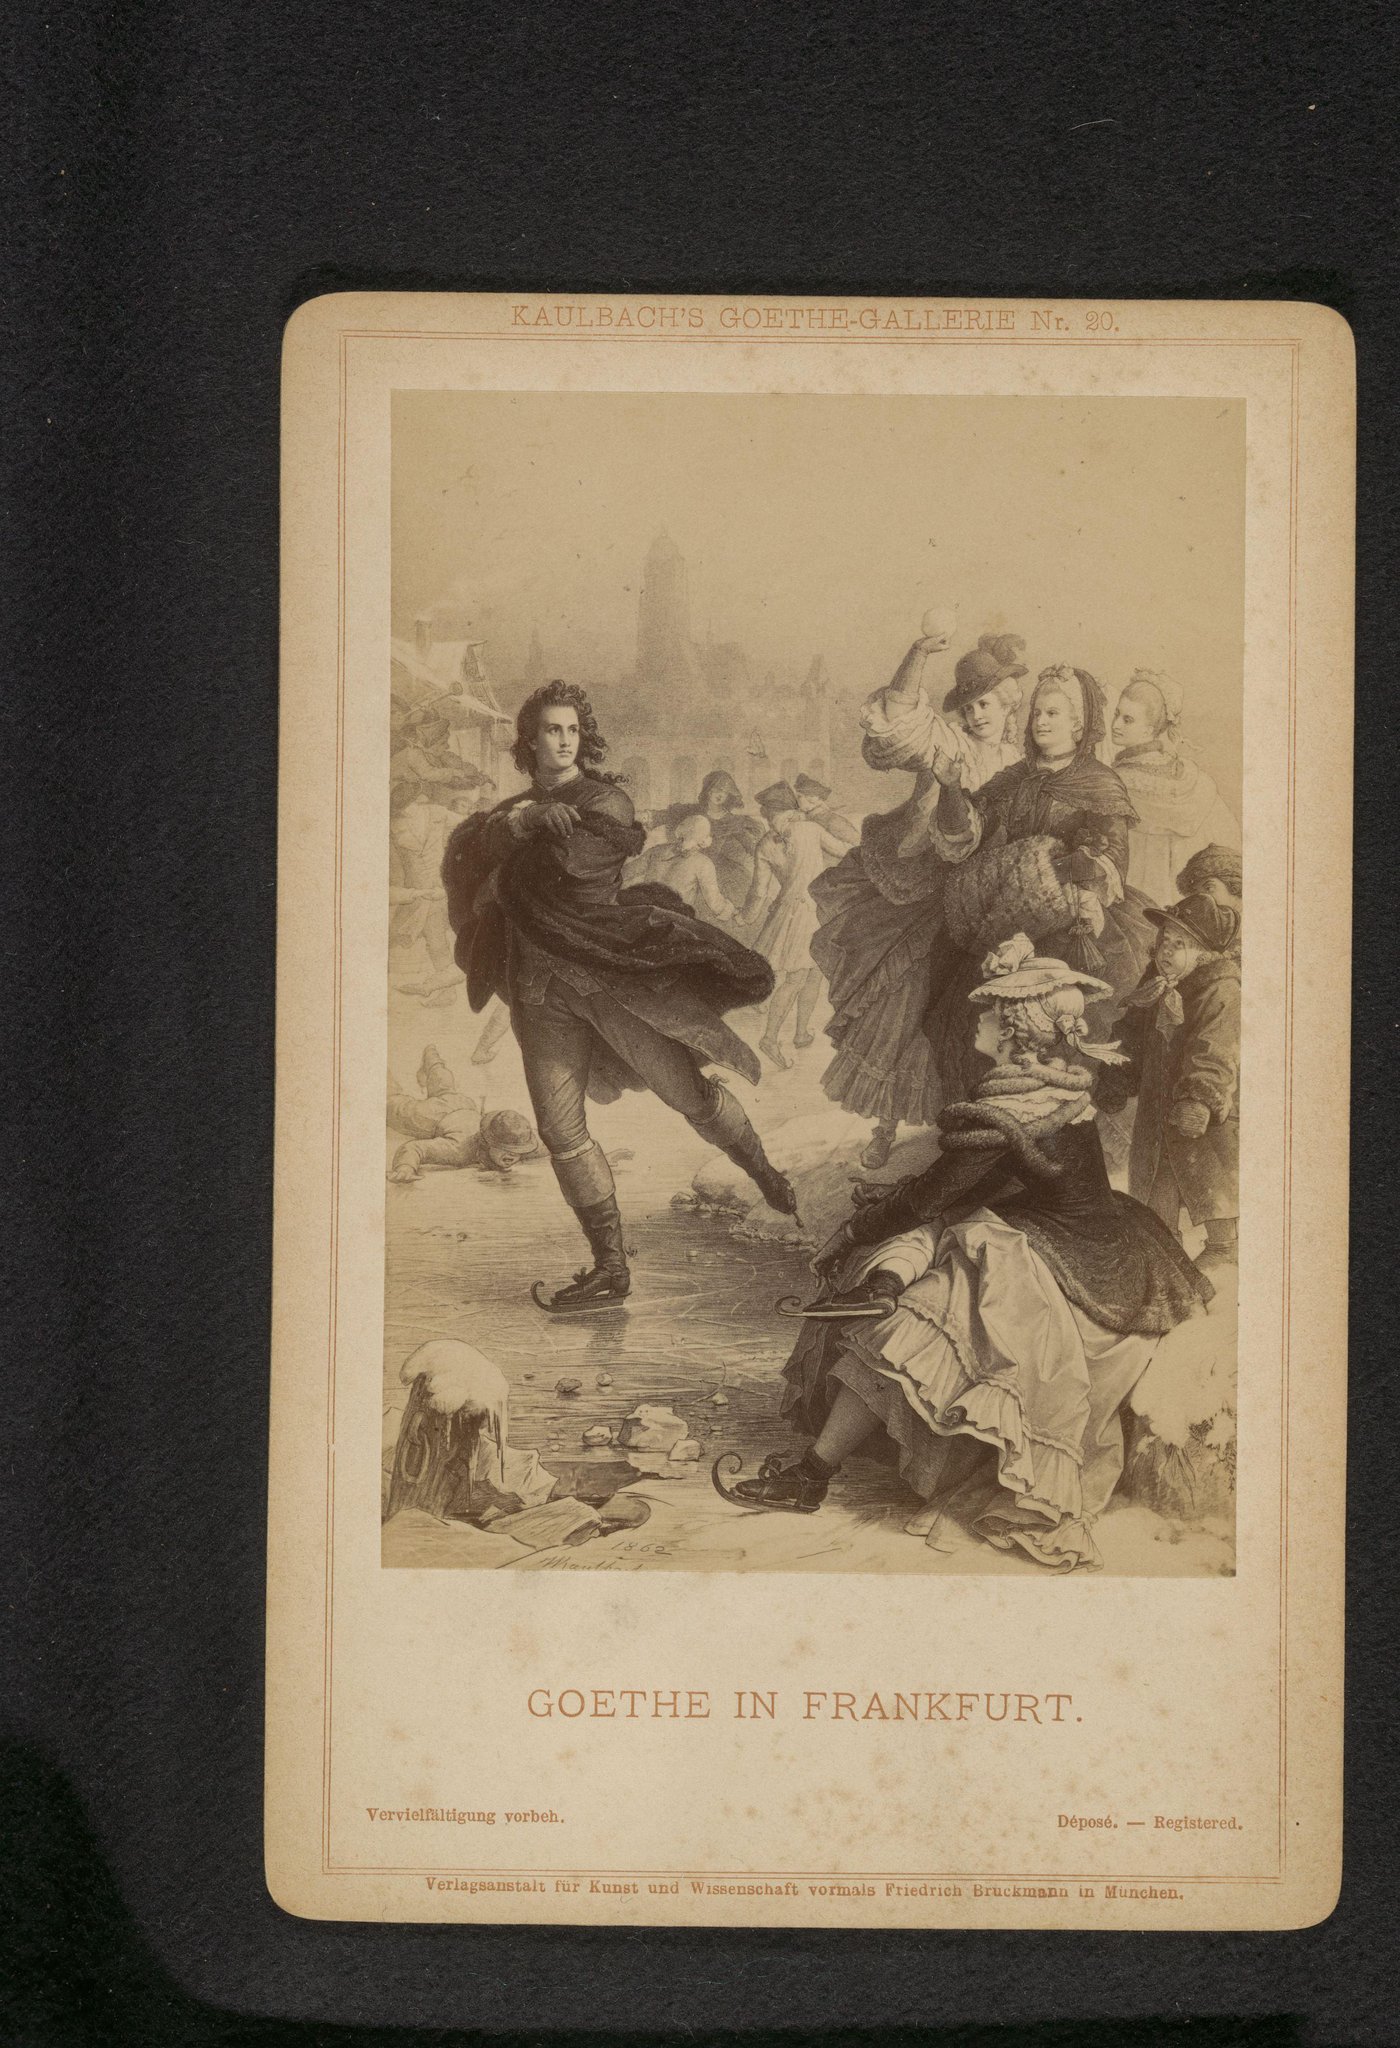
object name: photograph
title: Fotoreproductie van een voorstelling van Goethe in Frankfurt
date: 1880-1885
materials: photographic support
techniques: albumen print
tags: adult man, painting, drawing and the graphic arts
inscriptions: inscription: ‘Vervielfältigung vorbeh. Déposé - Registered./ Verlagsanstalt für Kunst und Wissenschaft vormals Friedrich Bruckmann in München.’, annotation: ‘24.12.94’, inscription: ‘Kaulbach's Goethe-Gallerie Nr. 20’, name: ‘Friedrich Bruckmann's Verlag/ München’